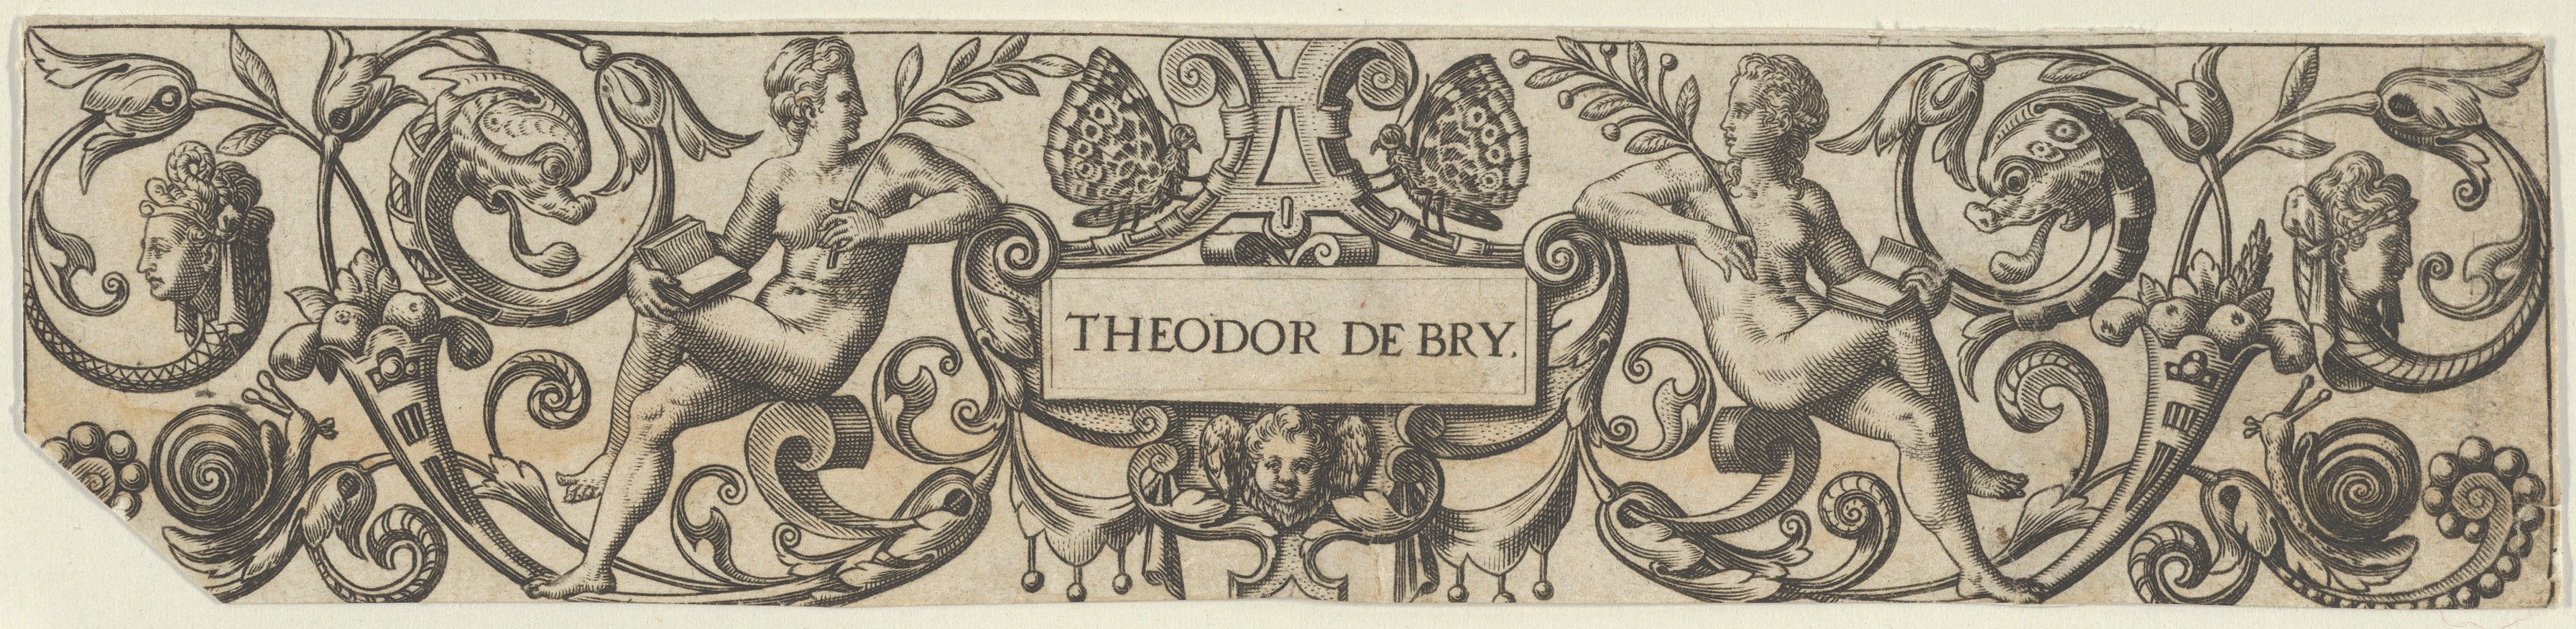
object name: print ornament architecture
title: Frieze with Two Female Figures Holding Books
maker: theodor de bry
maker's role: artist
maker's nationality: netherlandish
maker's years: 1528-1598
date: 1590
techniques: engraving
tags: female nudes